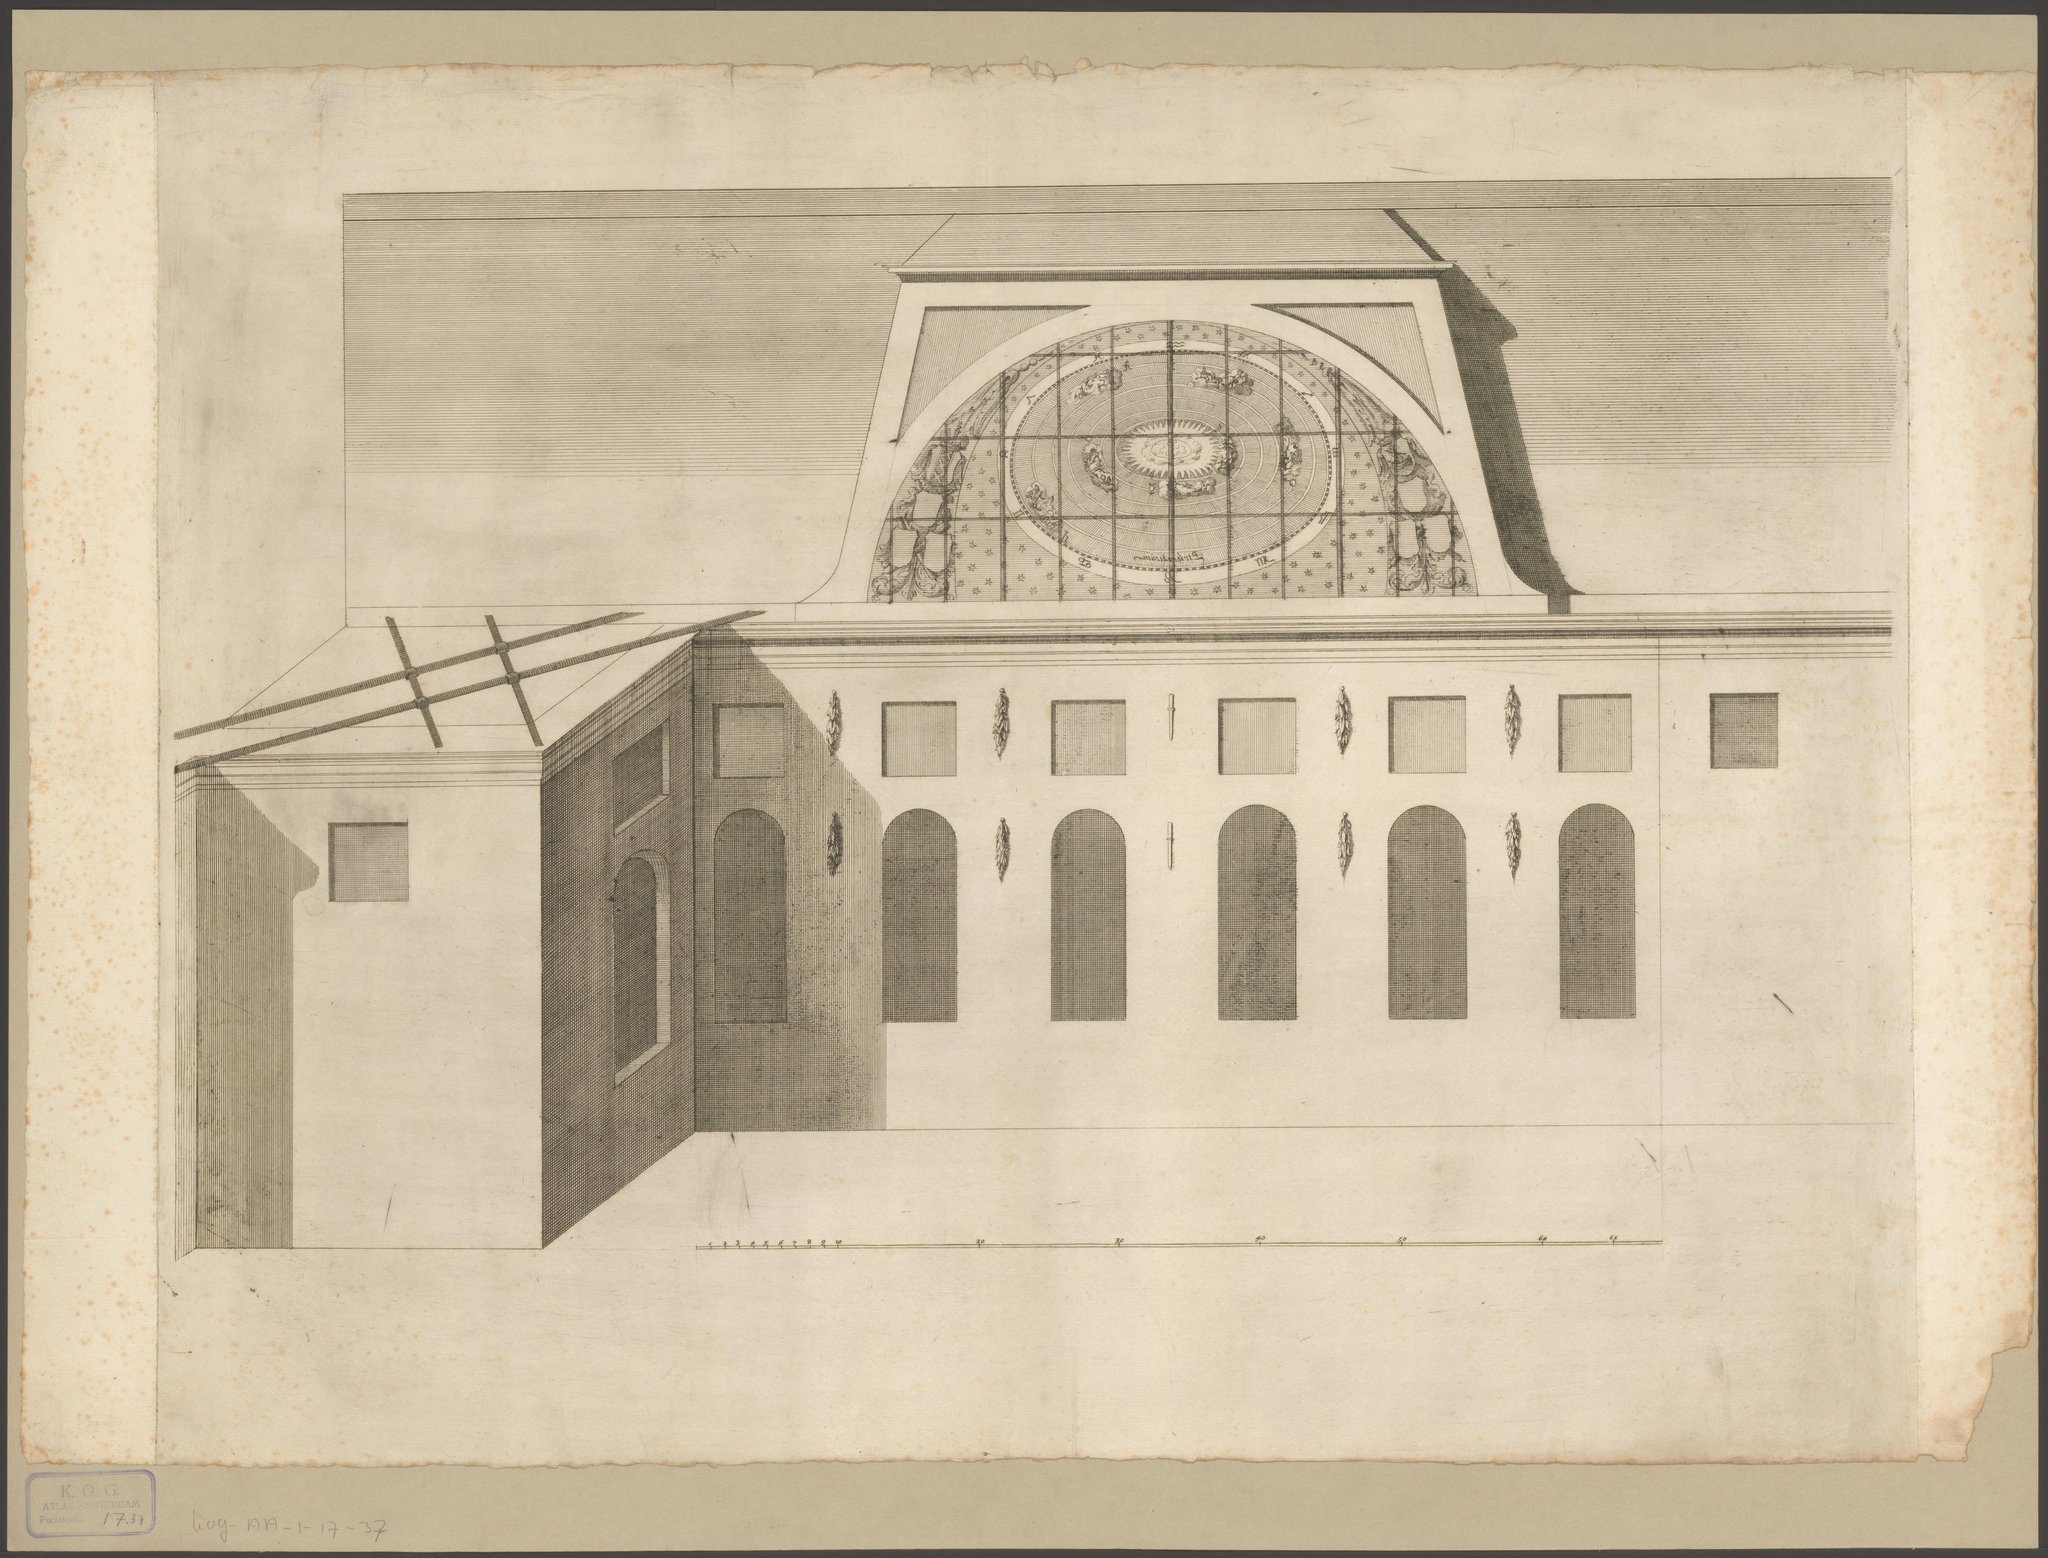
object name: print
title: Onuitgevoerd ontwerp voor de Burgerzaal van het Stadhuis op de Dam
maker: Anonymous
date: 1600-1650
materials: paper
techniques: engraving, etching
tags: townhall, plan ~ architecture, astrological signs and symbols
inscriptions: collector's mark: ‘17.37’ Lugt 1641b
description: Onderwerpsrubriek binnen de Atlas Amsterdam: Nieuwe Stadhuis, van binnen: Kap, Plattegronden, Betimmering.